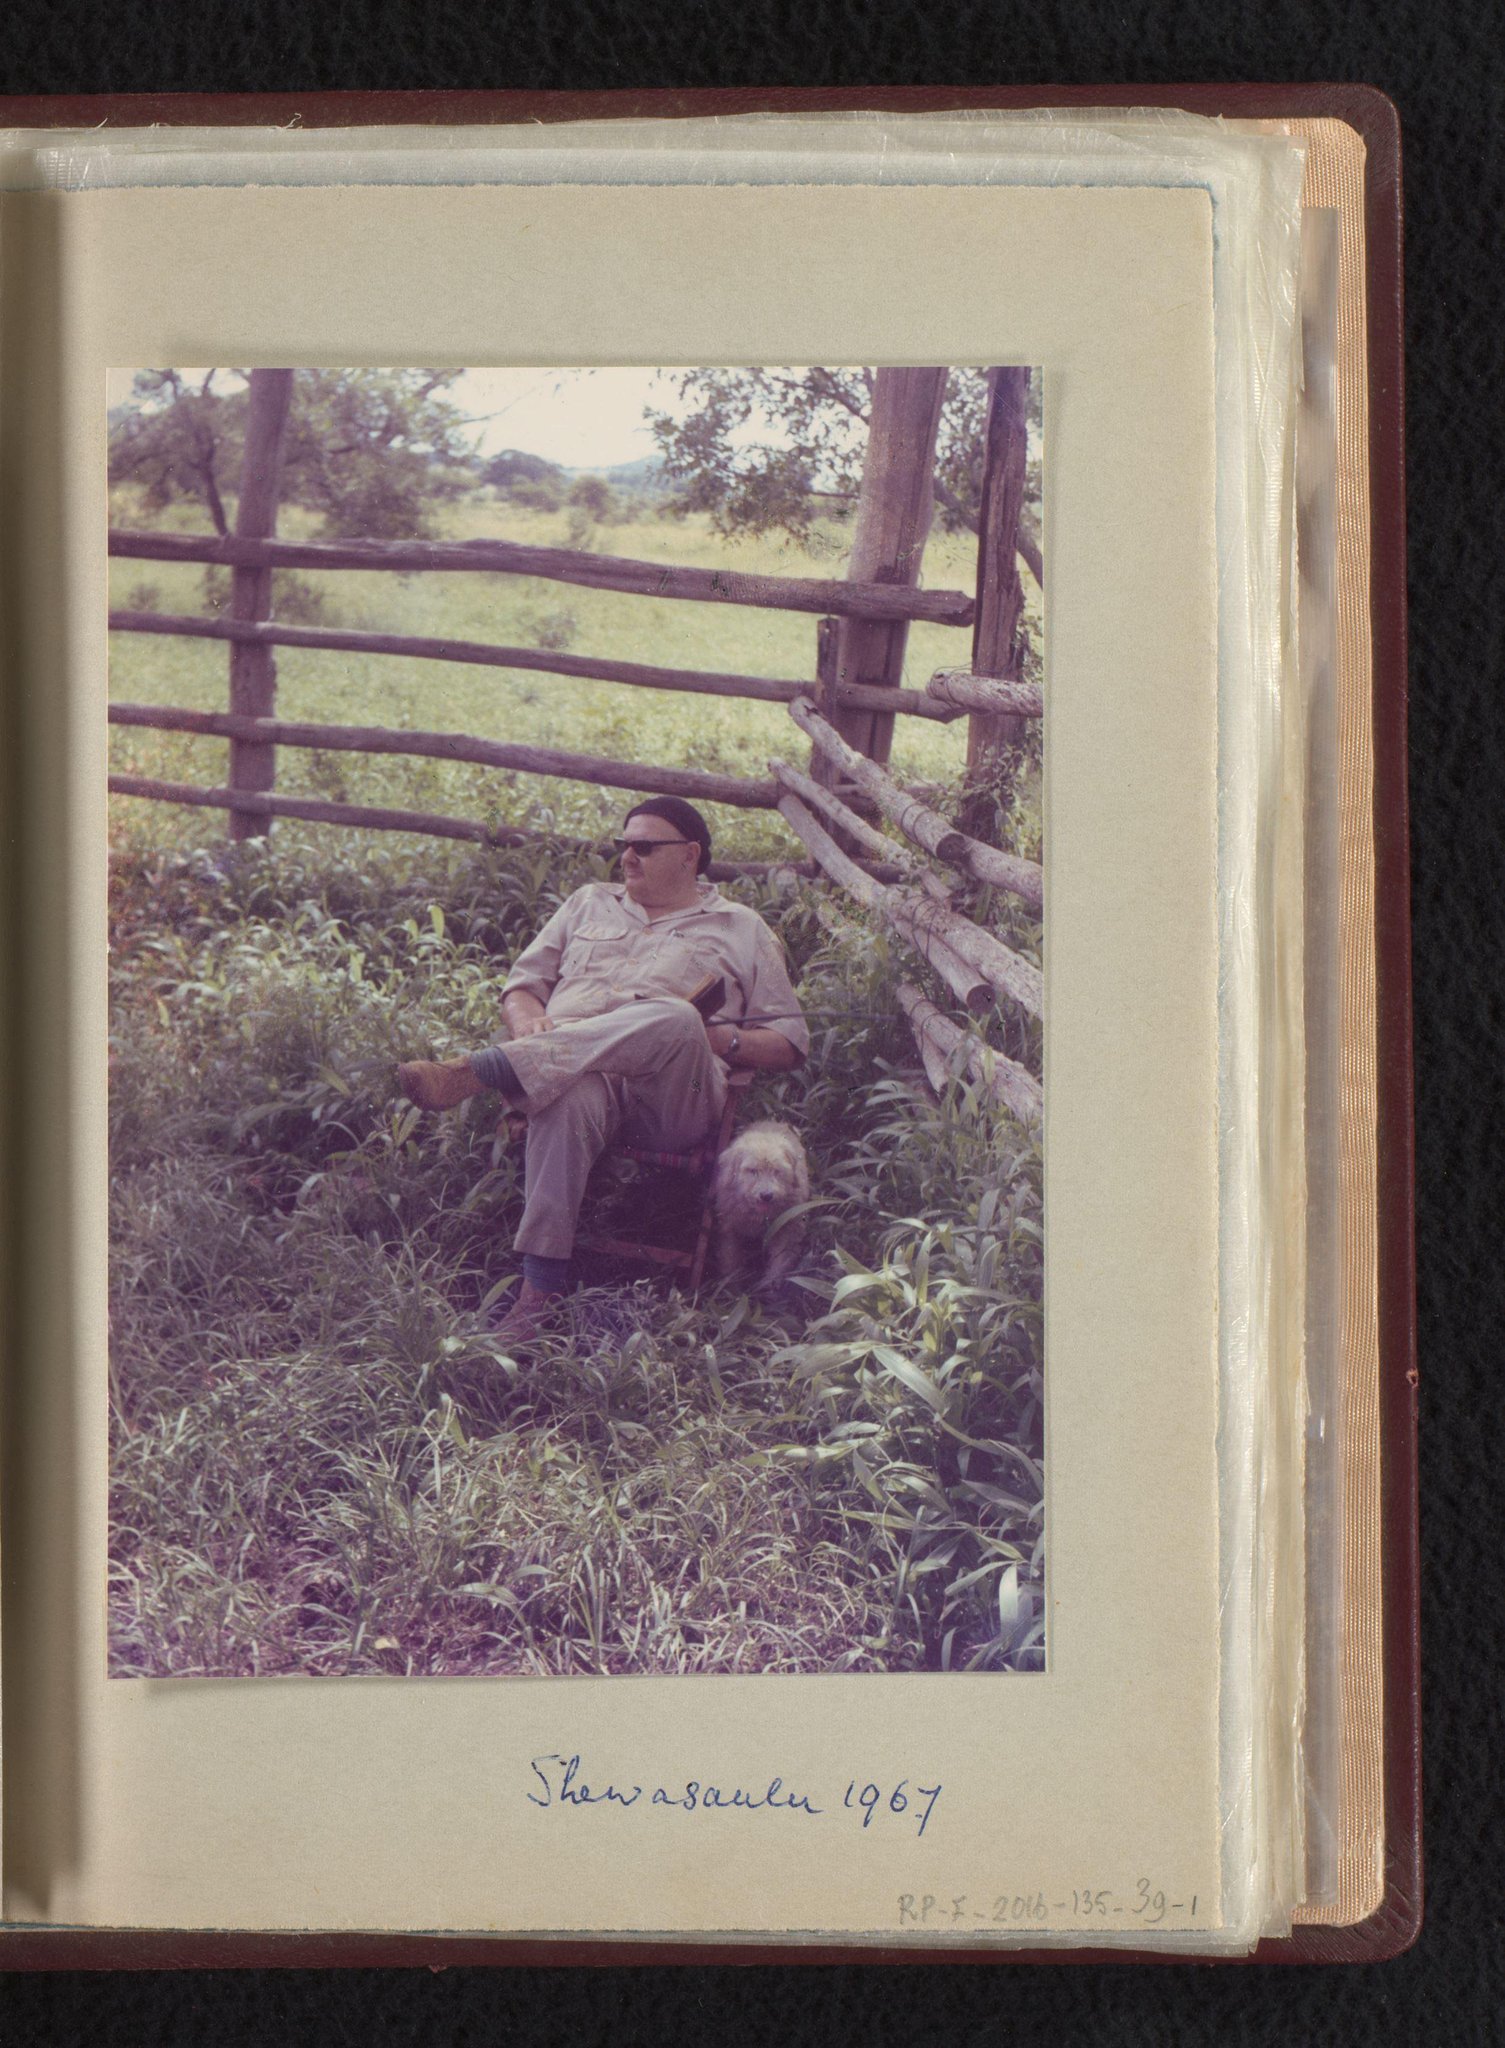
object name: album leaf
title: Portret van Willem Jacob van den Berg met een hond in Shewasaulu, Zuid-Afrika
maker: willem jacob van den berg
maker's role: boer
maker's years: 1902-1983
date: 1967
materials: paper, cardboard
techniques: chromogenic print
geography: shewasaulu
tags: amsterdam, willem jacob van den berg, historical persons